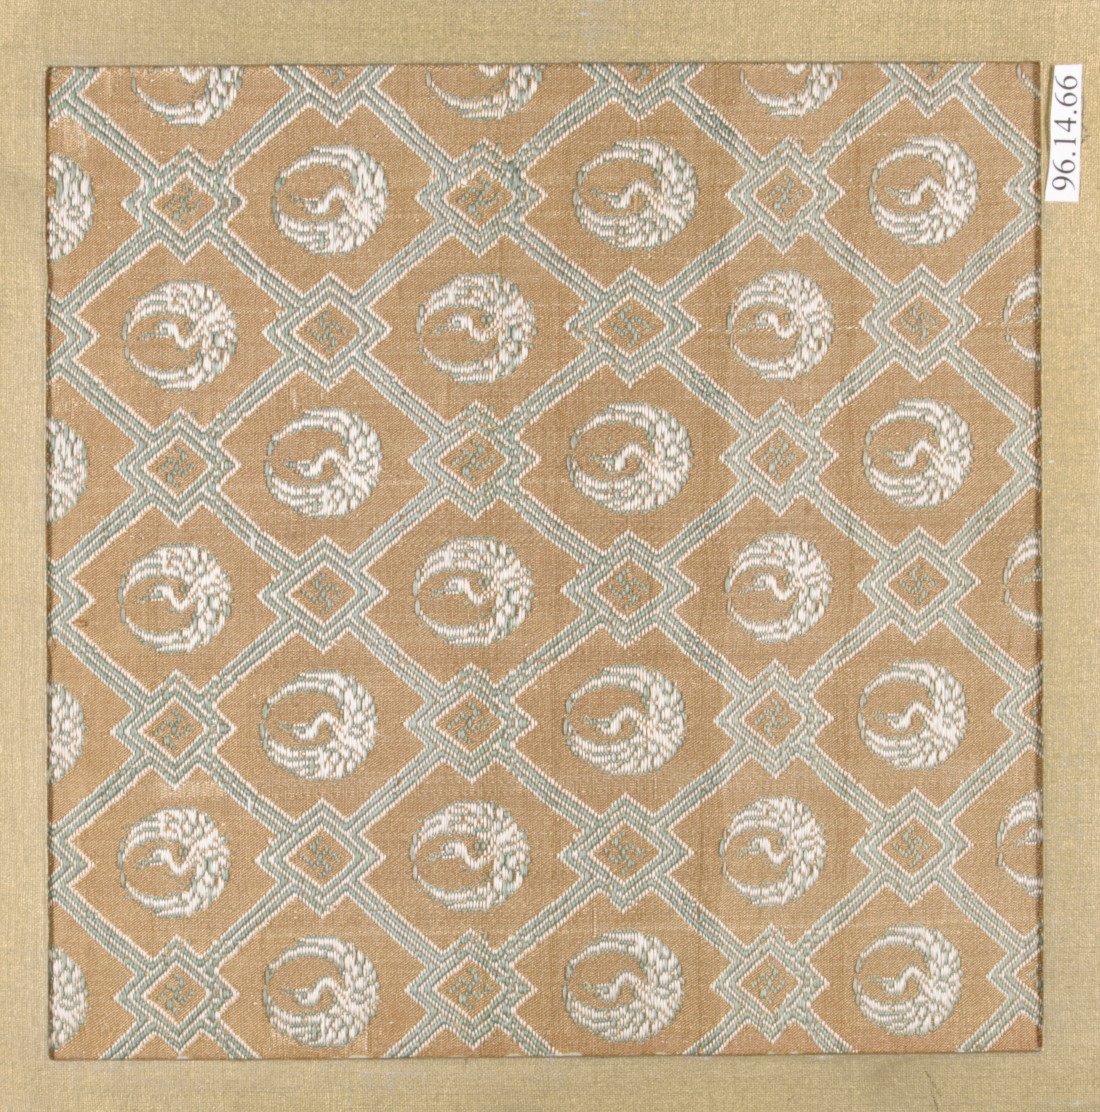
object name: piece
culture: japanese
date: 1701-1800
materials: silk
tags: birds